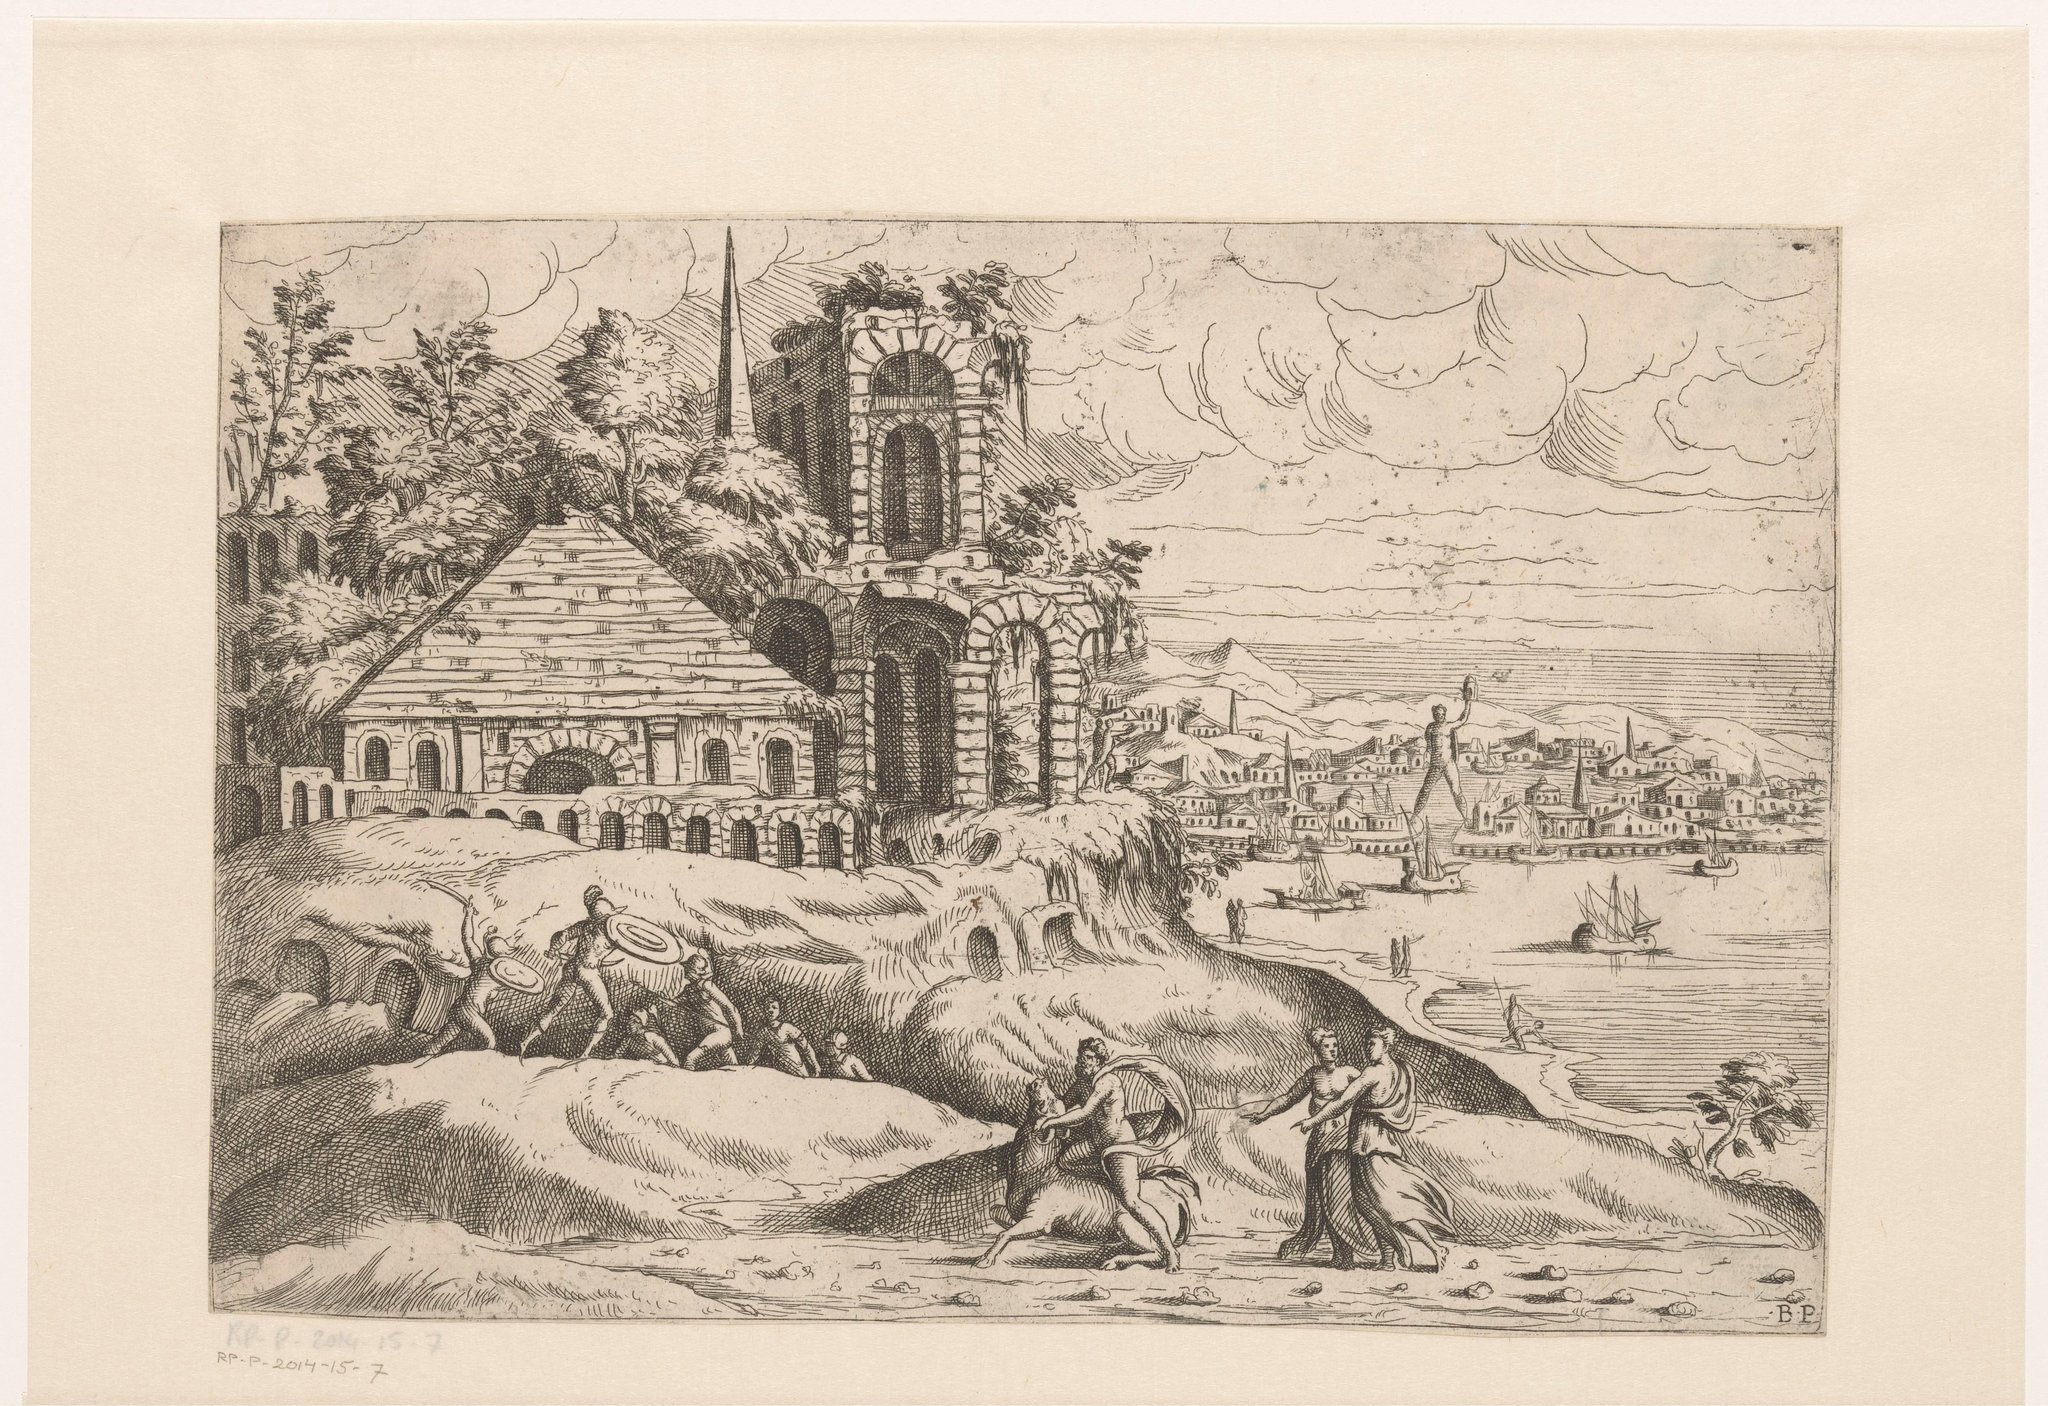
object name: print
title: Stadsgezicht met ruïnes, fantasie-architectuur en een kolossaal beeld op de achtergrond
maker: giovanni battista pittoni (i)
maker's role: print maker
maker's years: 1520-1583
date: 1560-1570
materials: paper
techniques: etching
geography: vicenza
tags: landscape with ruins, fantastic architecture, unrealistic architectural fantasies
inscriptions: collector's mark: Lugt 2760, collector's mark: Lugt 2228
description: Stadsgezicht met ruïnes, fantasie-architectuur en een kolossaal beeld op de achtergrond. Op de voorgrond bedwingt een man een stier. Prent uit een serie landschappen met ruïnes en fantasie-architectuur.